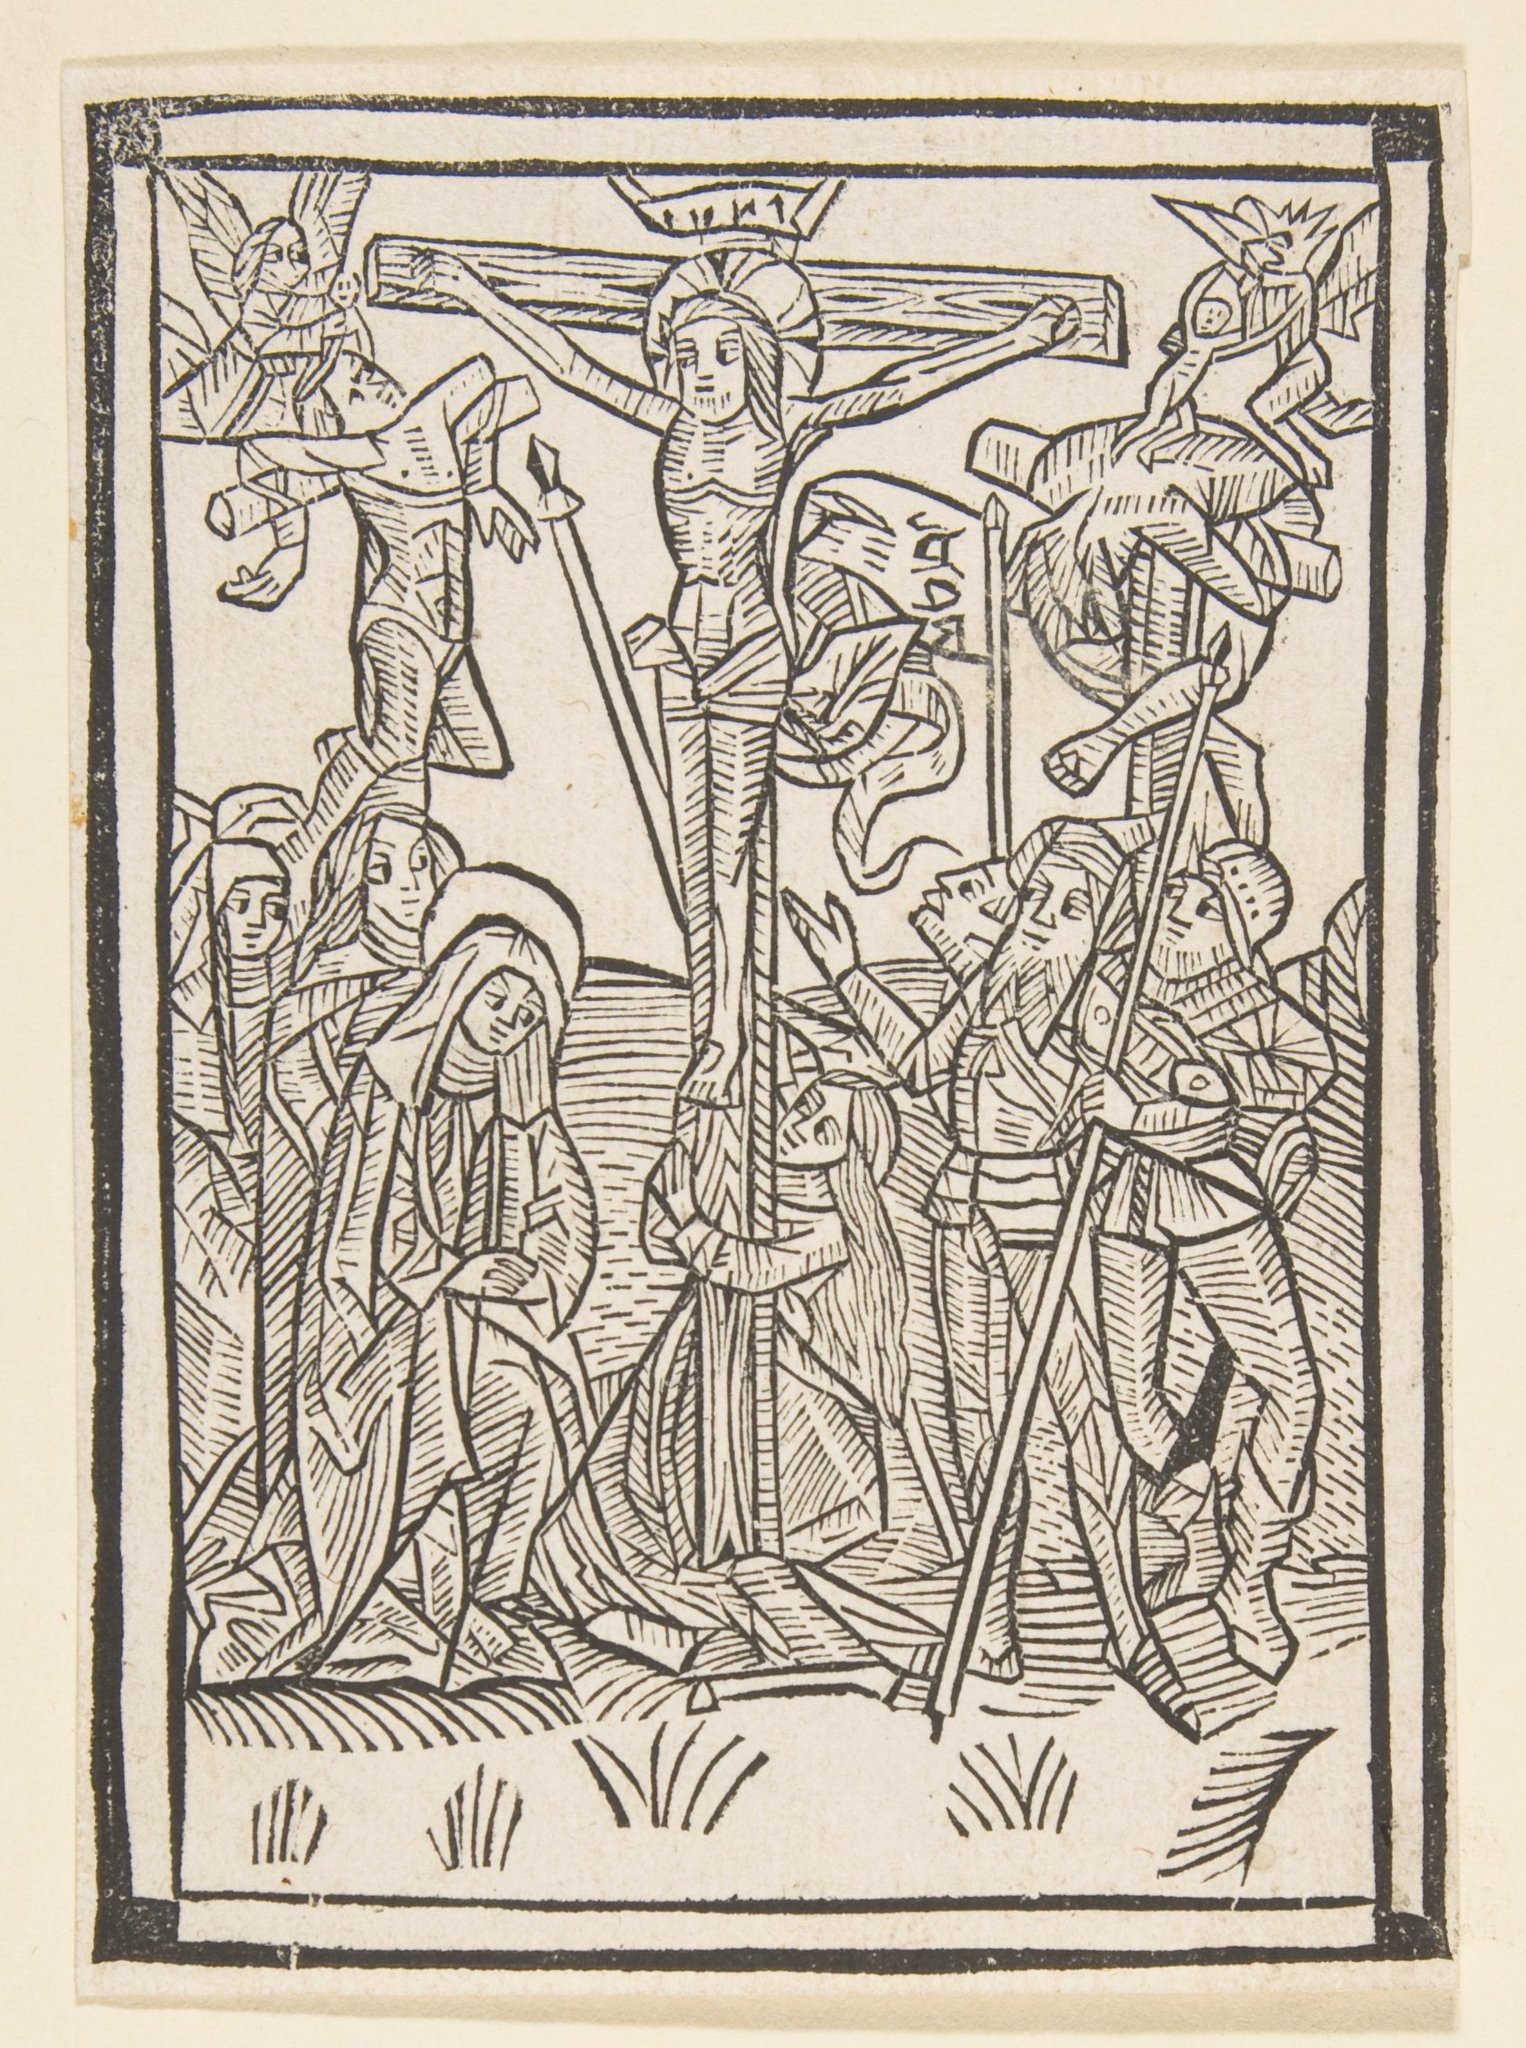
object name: print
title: The Crucifixion, frontispiece to Postilla Guillermi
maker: anonymous, german, 15th century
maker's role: artist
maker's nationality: german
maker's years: 1400-1500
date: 1491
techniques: woodcut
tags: men,christ,crucifixion